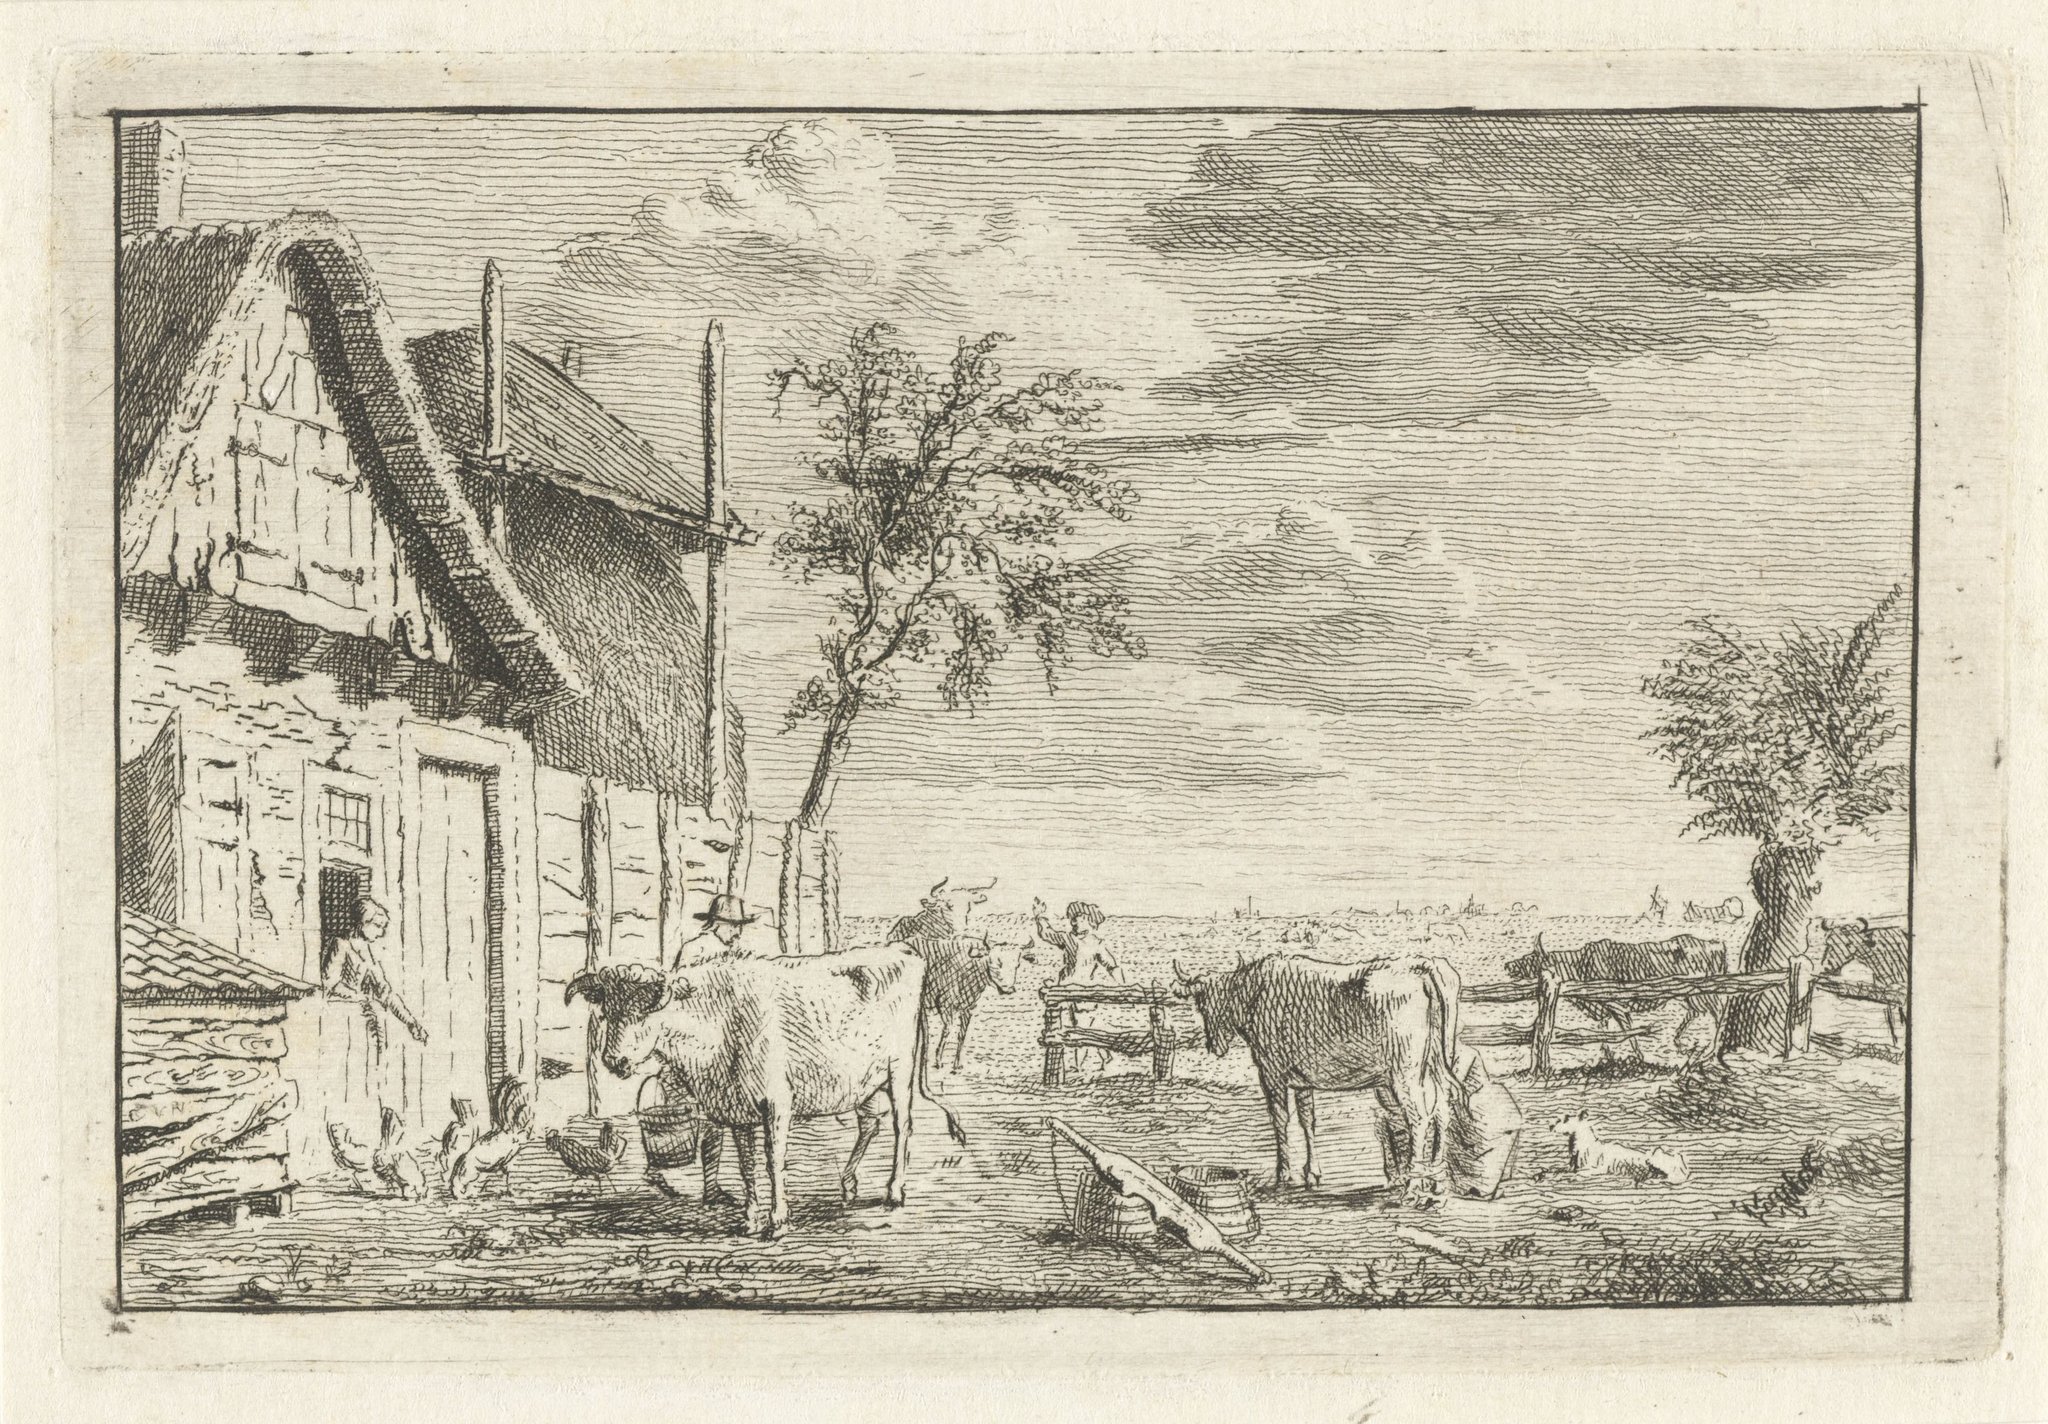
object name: print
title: Boerderij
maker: cornelis van noorde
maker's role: draughtsman, print maker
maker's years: 1731-1795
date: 1741-1795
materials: paper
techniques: etching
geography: haarlem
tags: cow, farm or solitary house in landscape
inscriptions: collector's mark: Lugt 2228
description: Een boerderij, met in de deuropening een vrouw, en daarnaast een hooiberg. Op het erf staan koeien, waarvan één wordt gemolken.